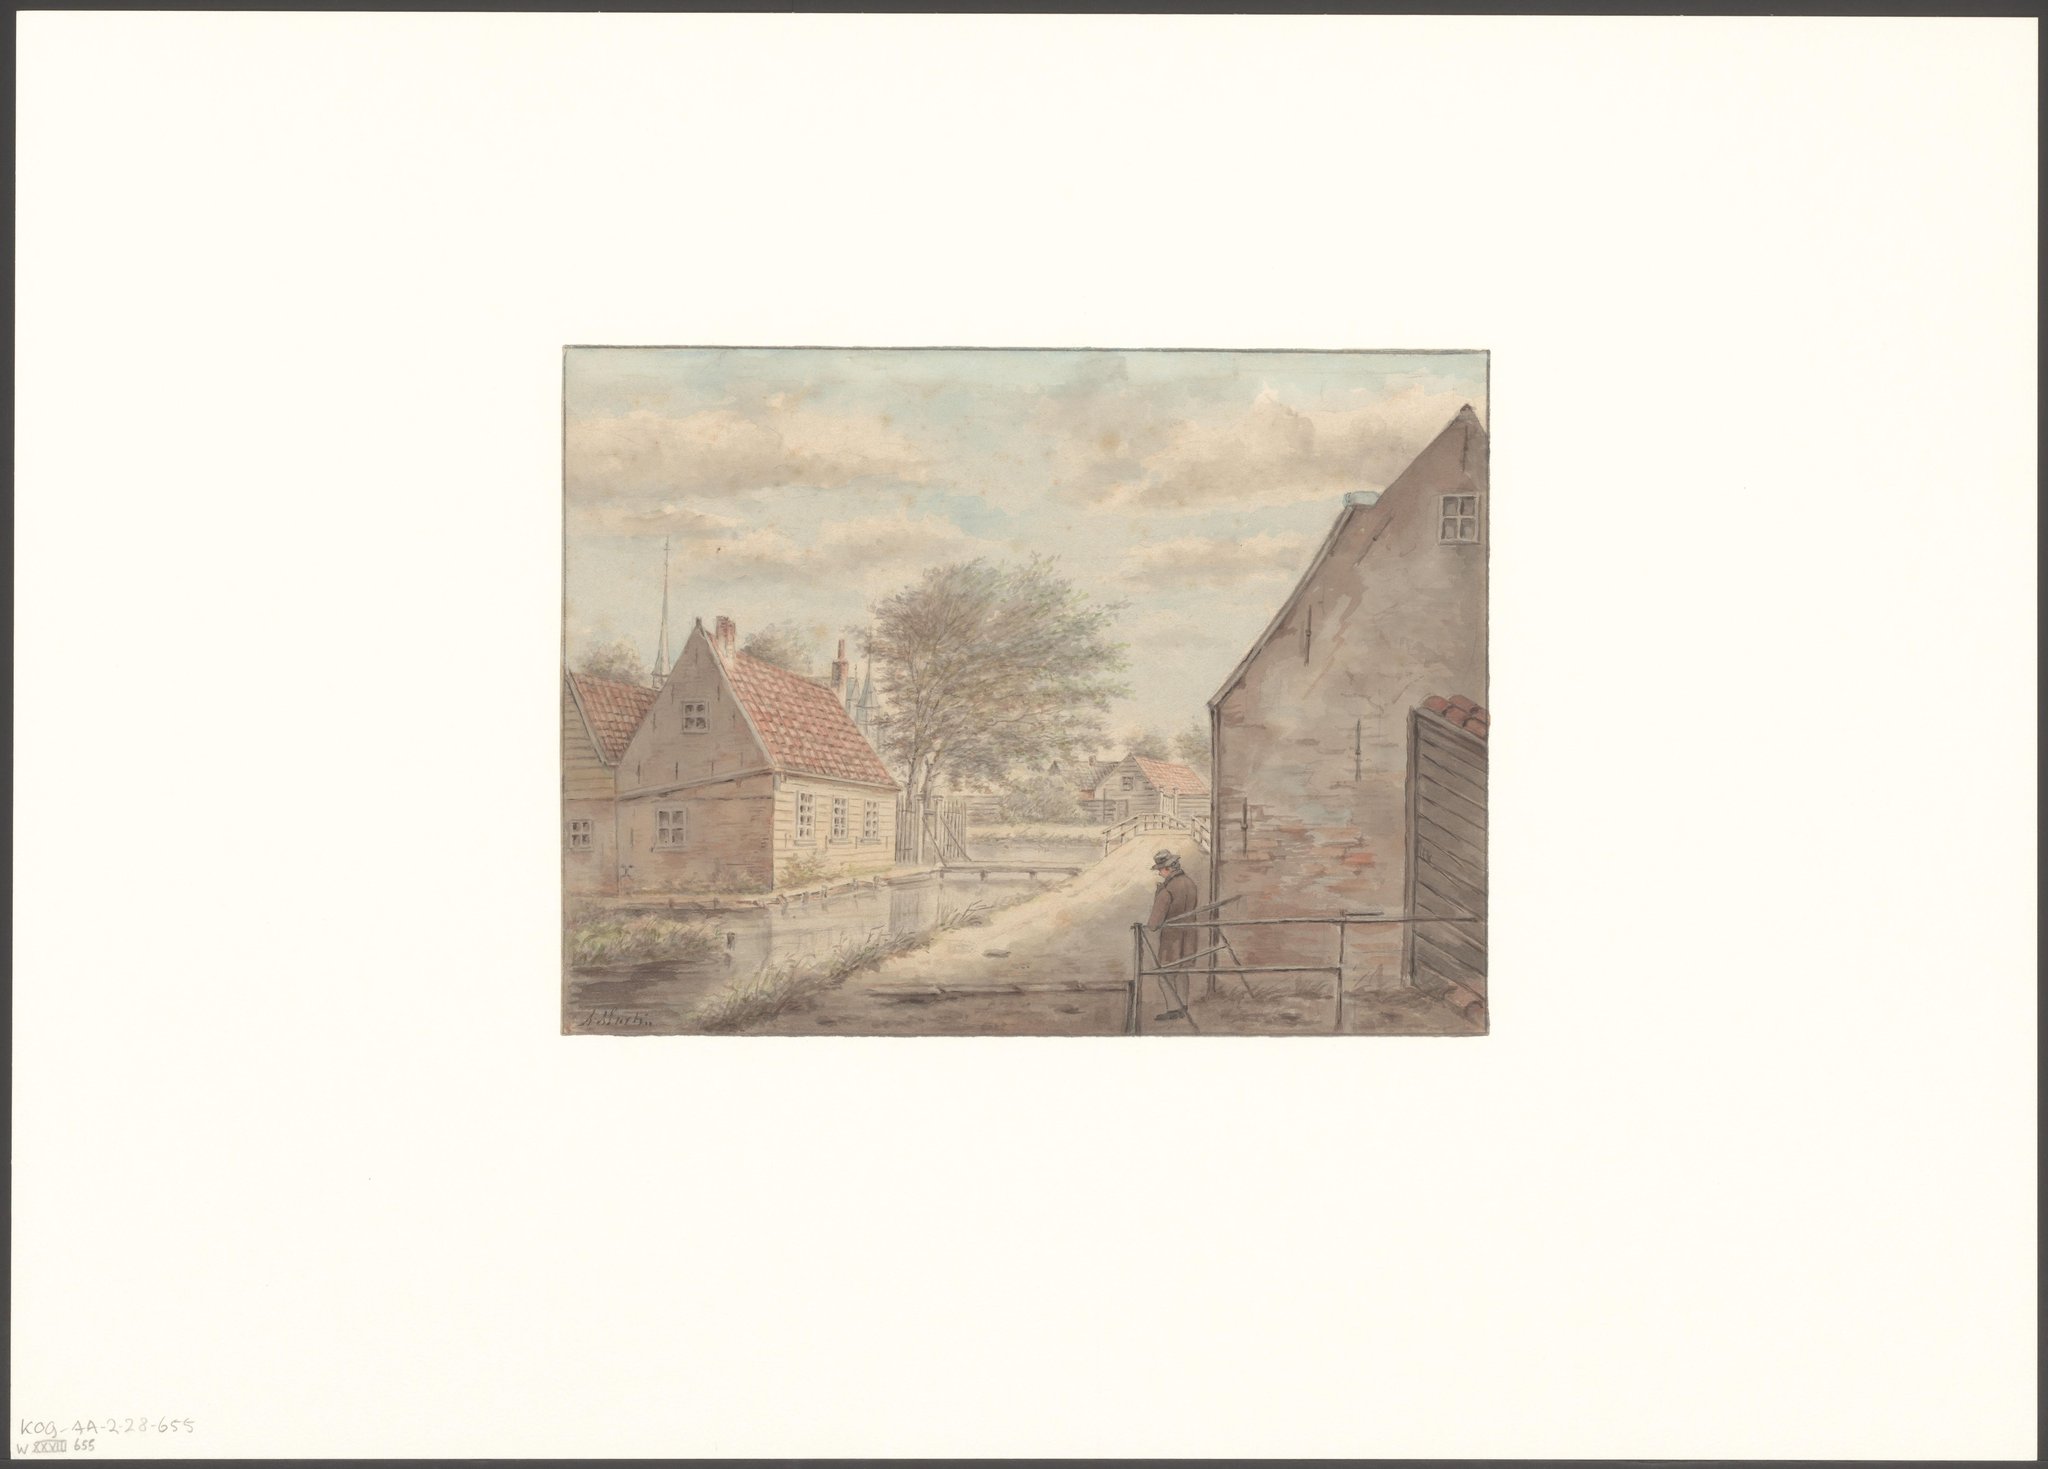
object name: drawing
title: Gezicht op het Kerkpad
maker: albert martin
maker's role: draughtsman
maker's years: 1827-1900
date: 1892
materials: ink, paper, pencil, watercolor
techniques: brush, pen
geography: amsterdam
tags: city-view in general; 'veduta', canal, road, path, bridge in city across river, canal, etc.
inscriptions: inscription: ‘Kerkpad - 1892.’, signature: ‘A.Martin’, collector's mark: Lugt 800a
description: Tekening binnen de Atlas Van Eck ingedeeld op wijknummer 28.